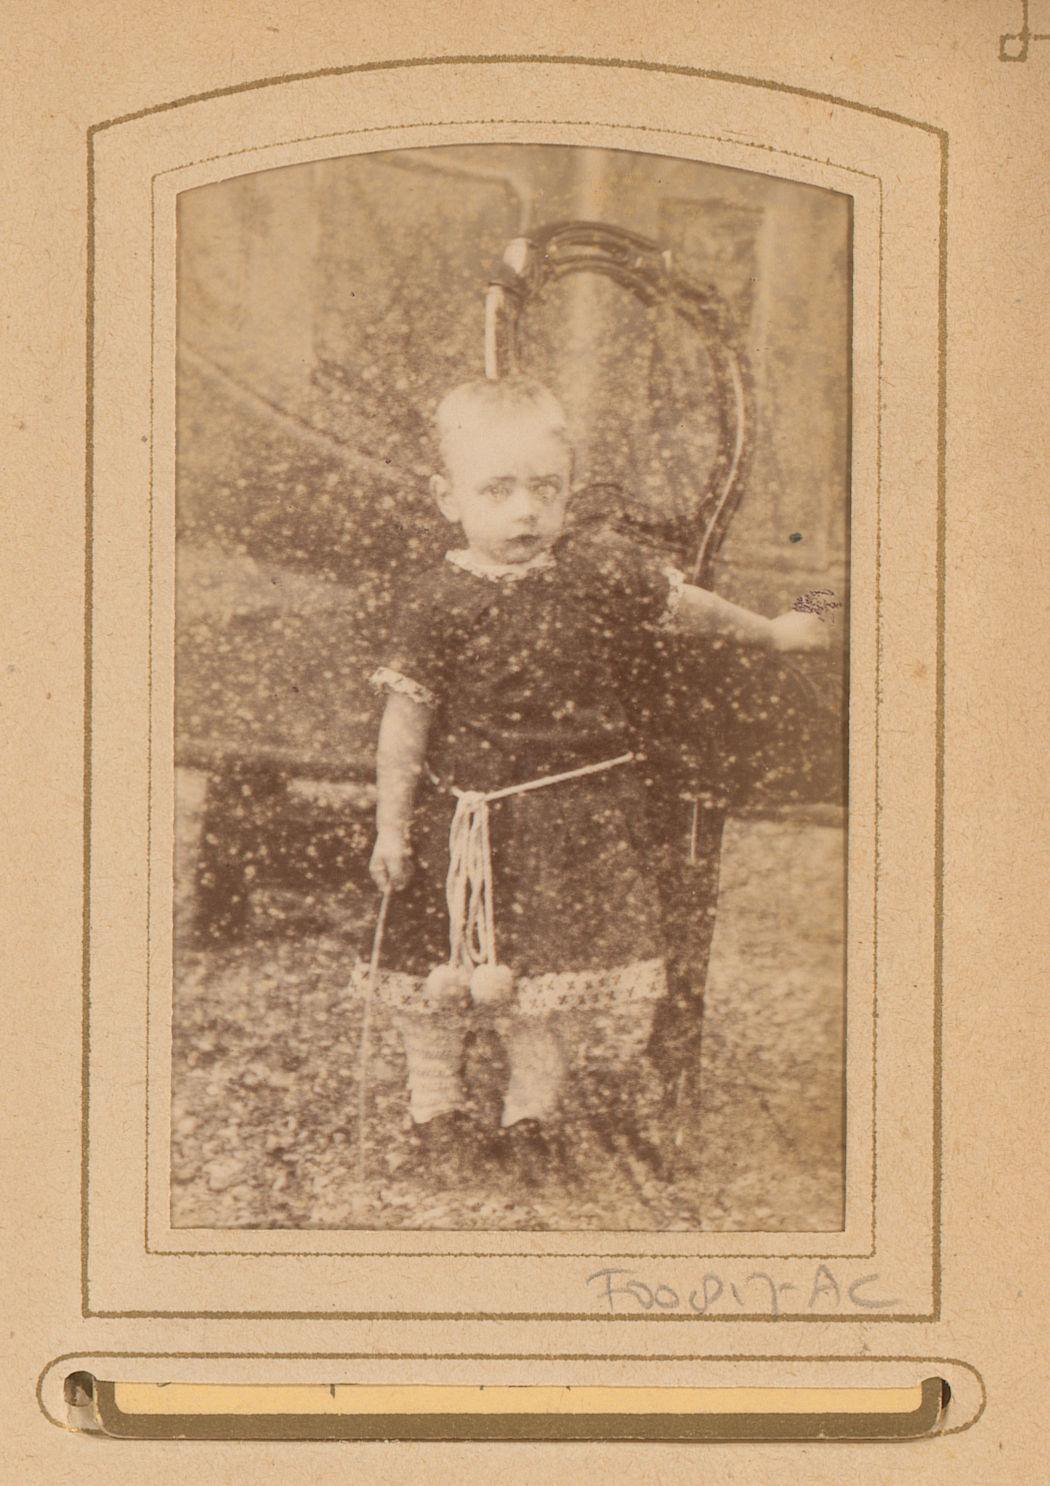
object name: carte de visite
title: Portret van een staand kind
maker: dirk schooneboom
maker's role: fotograaf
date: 1877-1914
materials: cardboard, photographic support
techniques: albumen print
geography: harderwijk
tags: child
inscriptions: inscription: ‘D. Schooneboom/ Harderwyk’